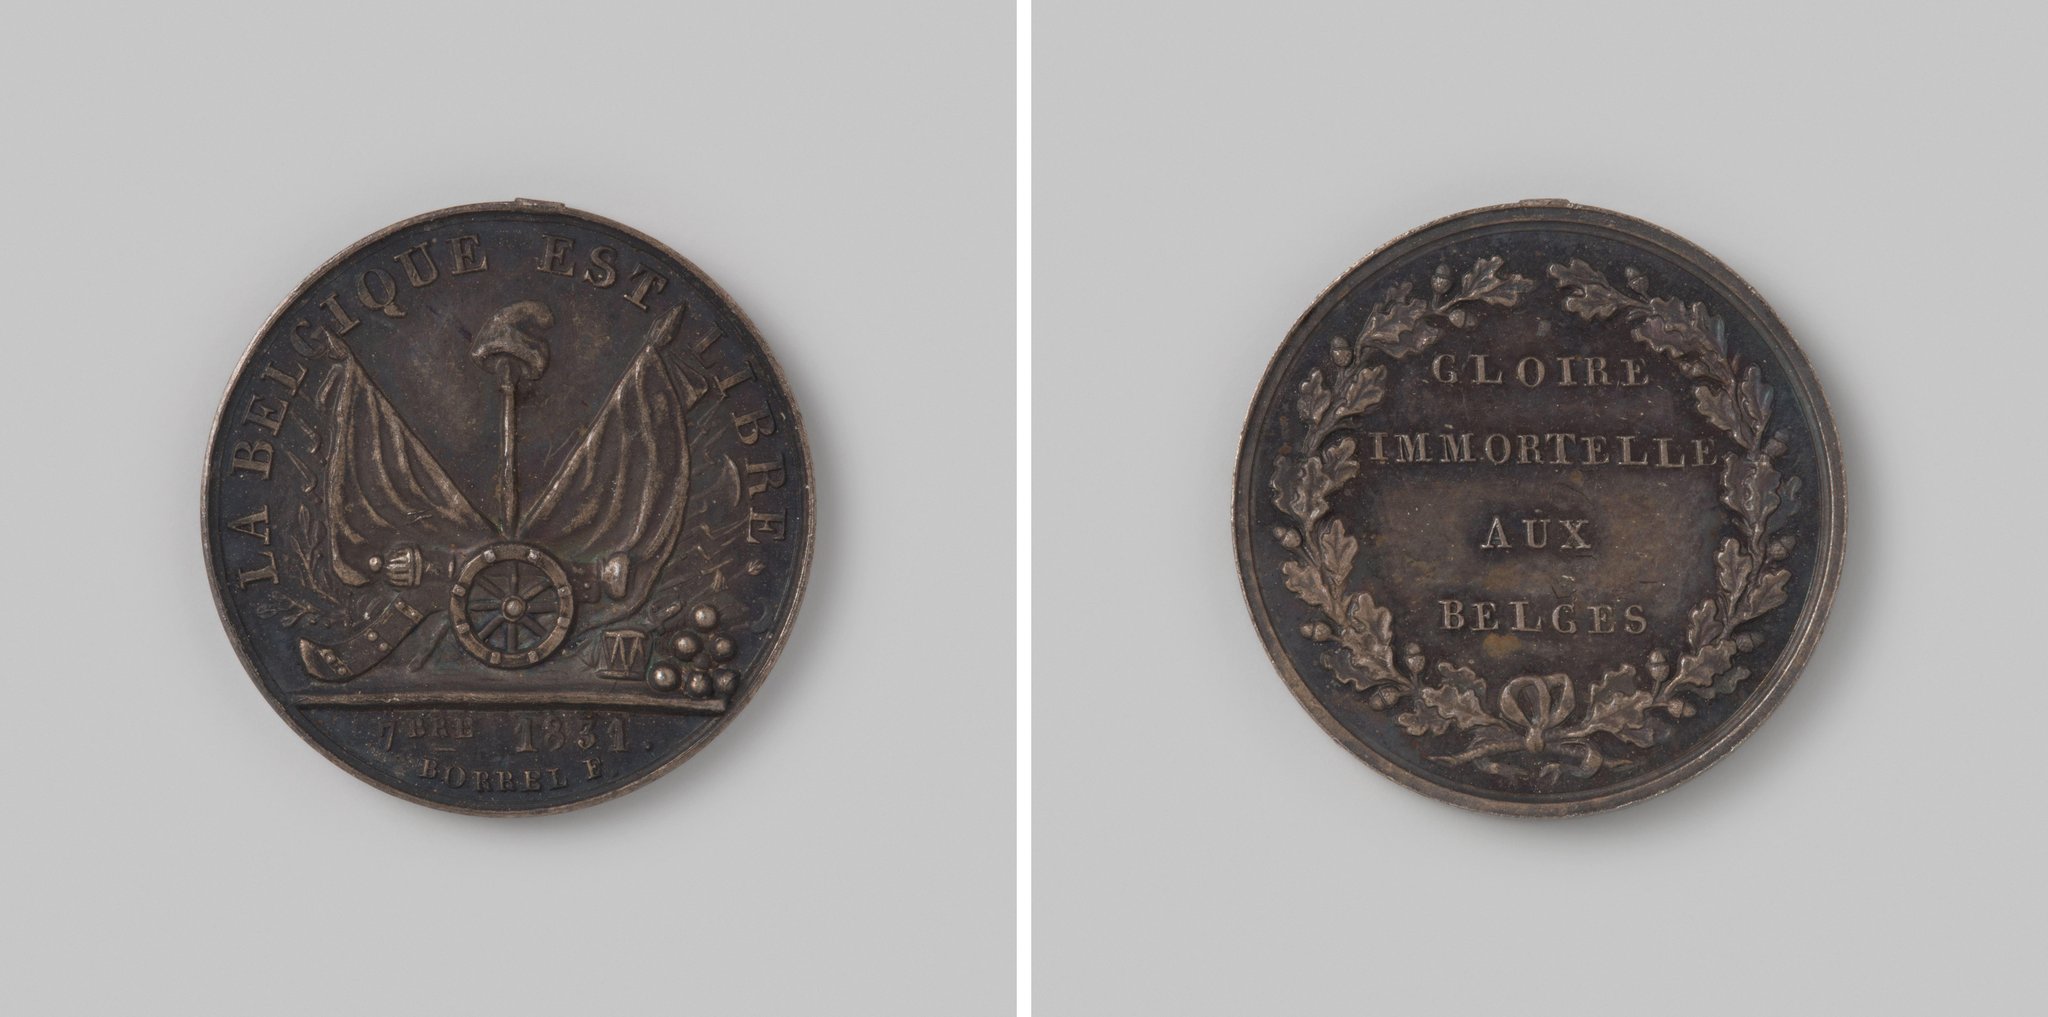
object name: strooipenning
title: Eerste verjaardag van de Belgische revolutie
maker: m. borrel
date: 1831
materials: silver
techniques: striking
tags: brussels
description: Zilveren penning. Voorzijde: trophee van wapentuig en vaandels met in midden staak, waarop vrijheids-muts rust binnen omschrift; afsnede: datering en signatuur. Keerzijde: opschrift binneneikekrans